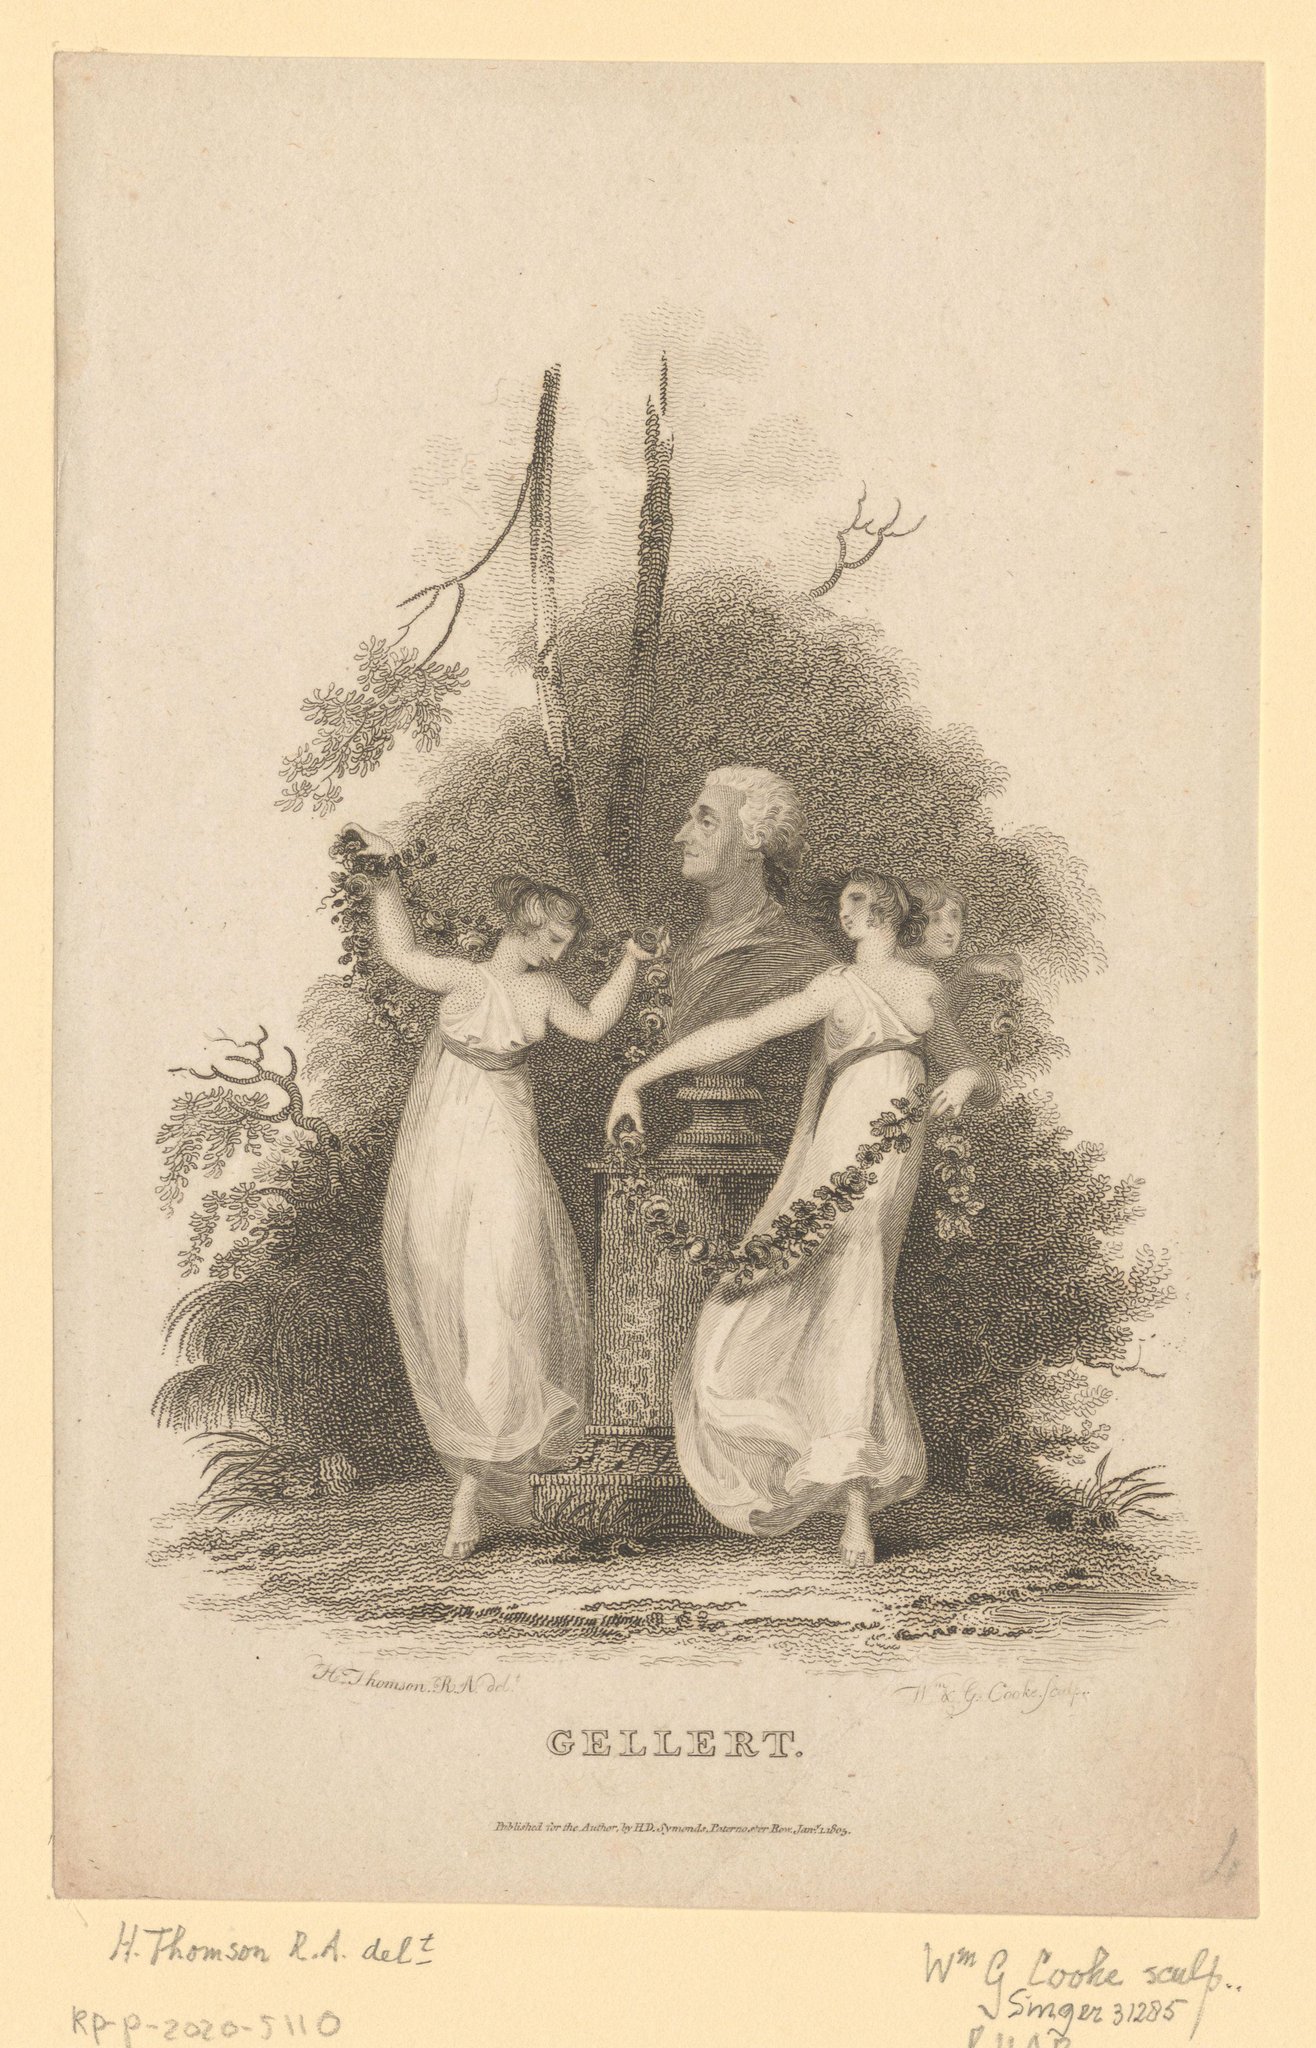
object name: print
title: Portret van Christian Furchtegott Gellert als beeld op een sokkel omringd door nimfen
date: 1803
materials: paper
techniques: engraving, etching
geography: london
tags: historical persons, nymphs (in general); 'ninfe in commune' (ripa), writer, poet, author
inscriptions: date